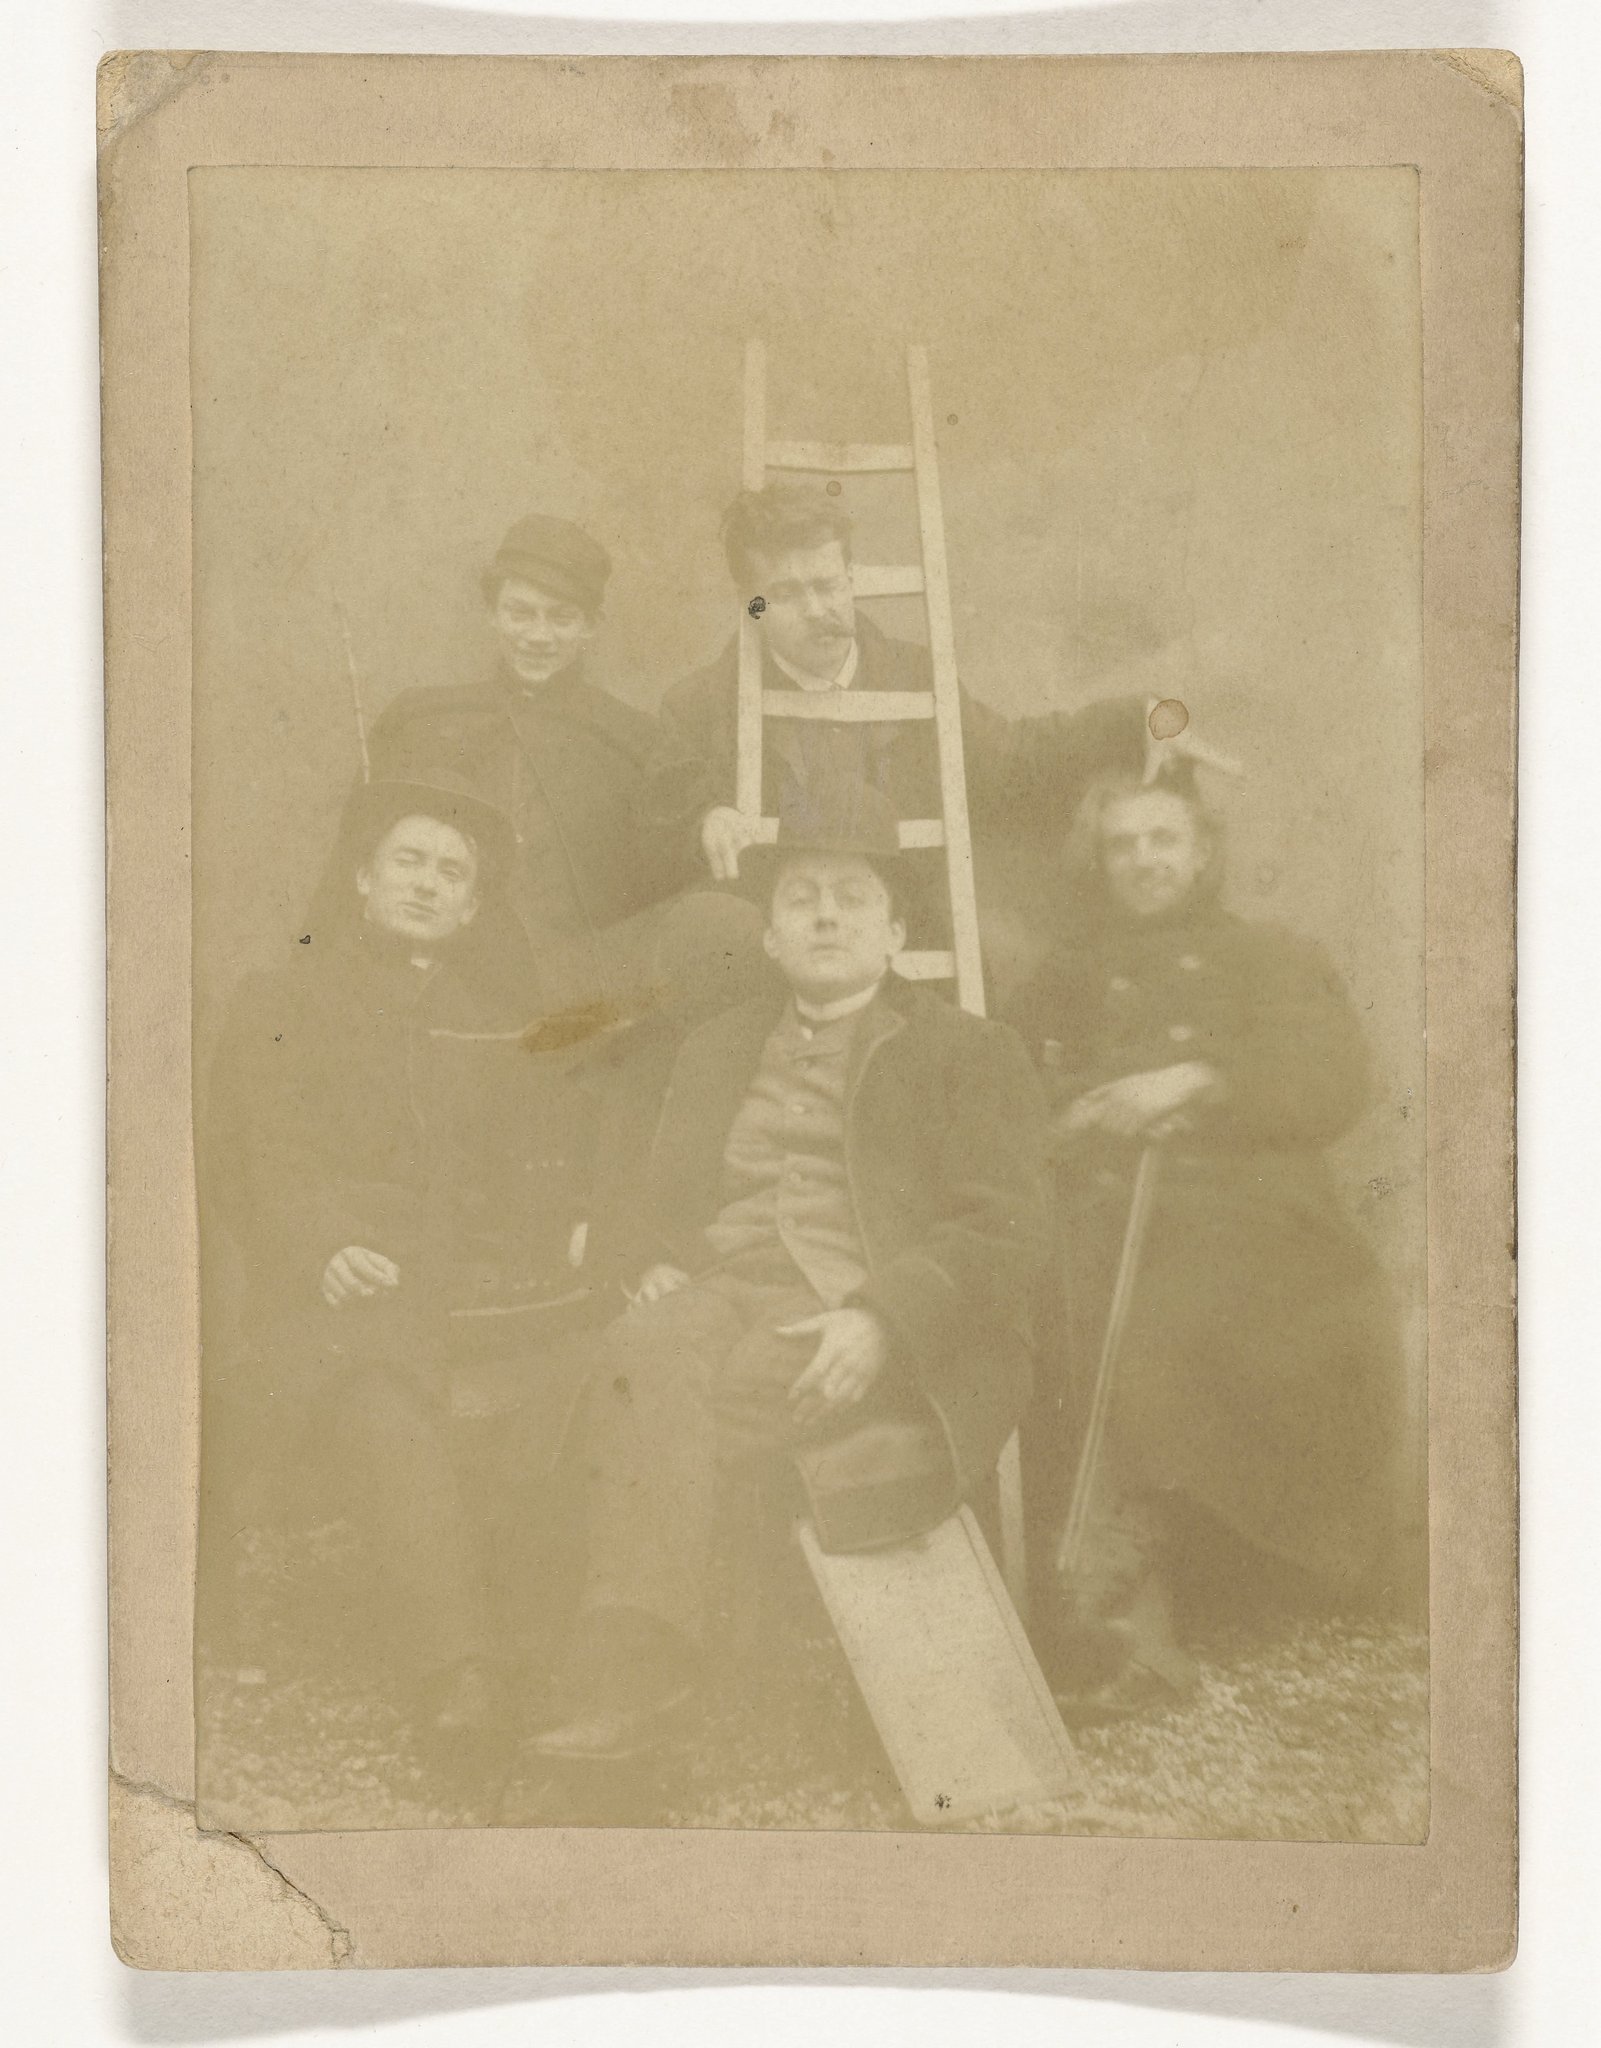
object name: photograph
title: Groepsportret van vijf studenten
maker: israël david kiek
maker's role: fotograaf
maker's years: 1811-1899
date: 1887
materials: cardboard, paper, photographic support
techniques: albumen print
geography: netherlands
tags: anonymous historical persons portrayed in a group, in a group-portrait, leiden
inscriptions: annotation: ‘Studenten Leiden’